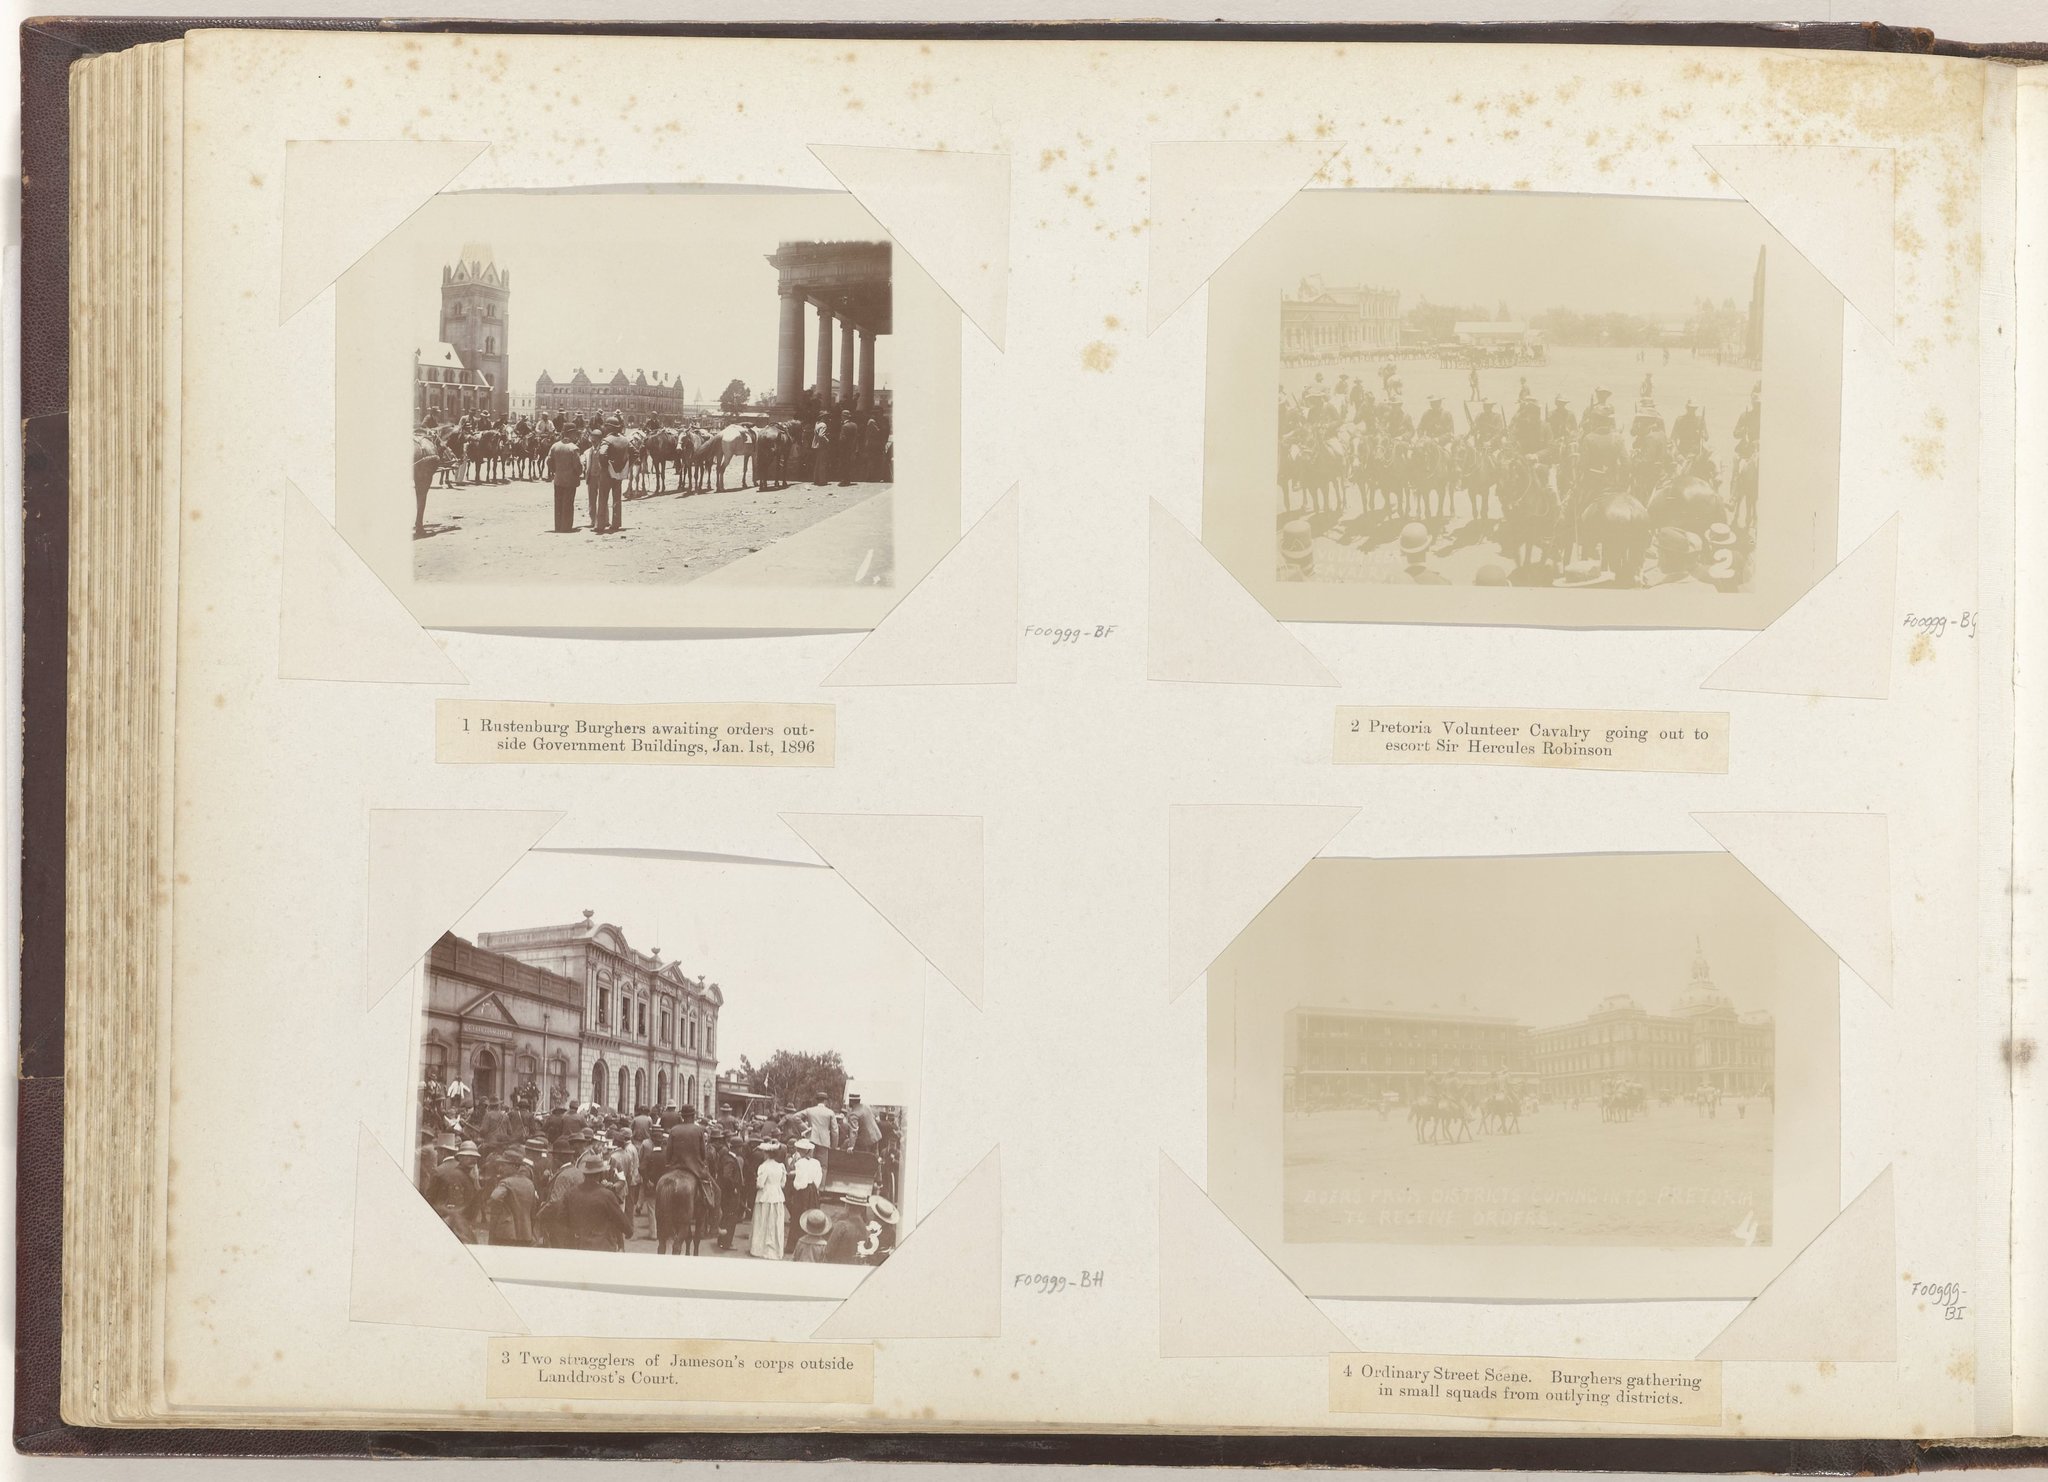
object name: photograph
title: Burgers van Rustenburg (Zuid-Afrika) bij regeringsgebouw in afwachting van nadere orders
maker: Anonymous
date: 1896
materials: paper, photographic support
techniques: gelatin silver print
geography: rustenburg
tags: land forces (+ cavalry, horsemen), street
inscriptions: inscription: ‘1’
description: Onderdeel van Album met 191 foto's van een reis naar en door Zuid-Afrika.